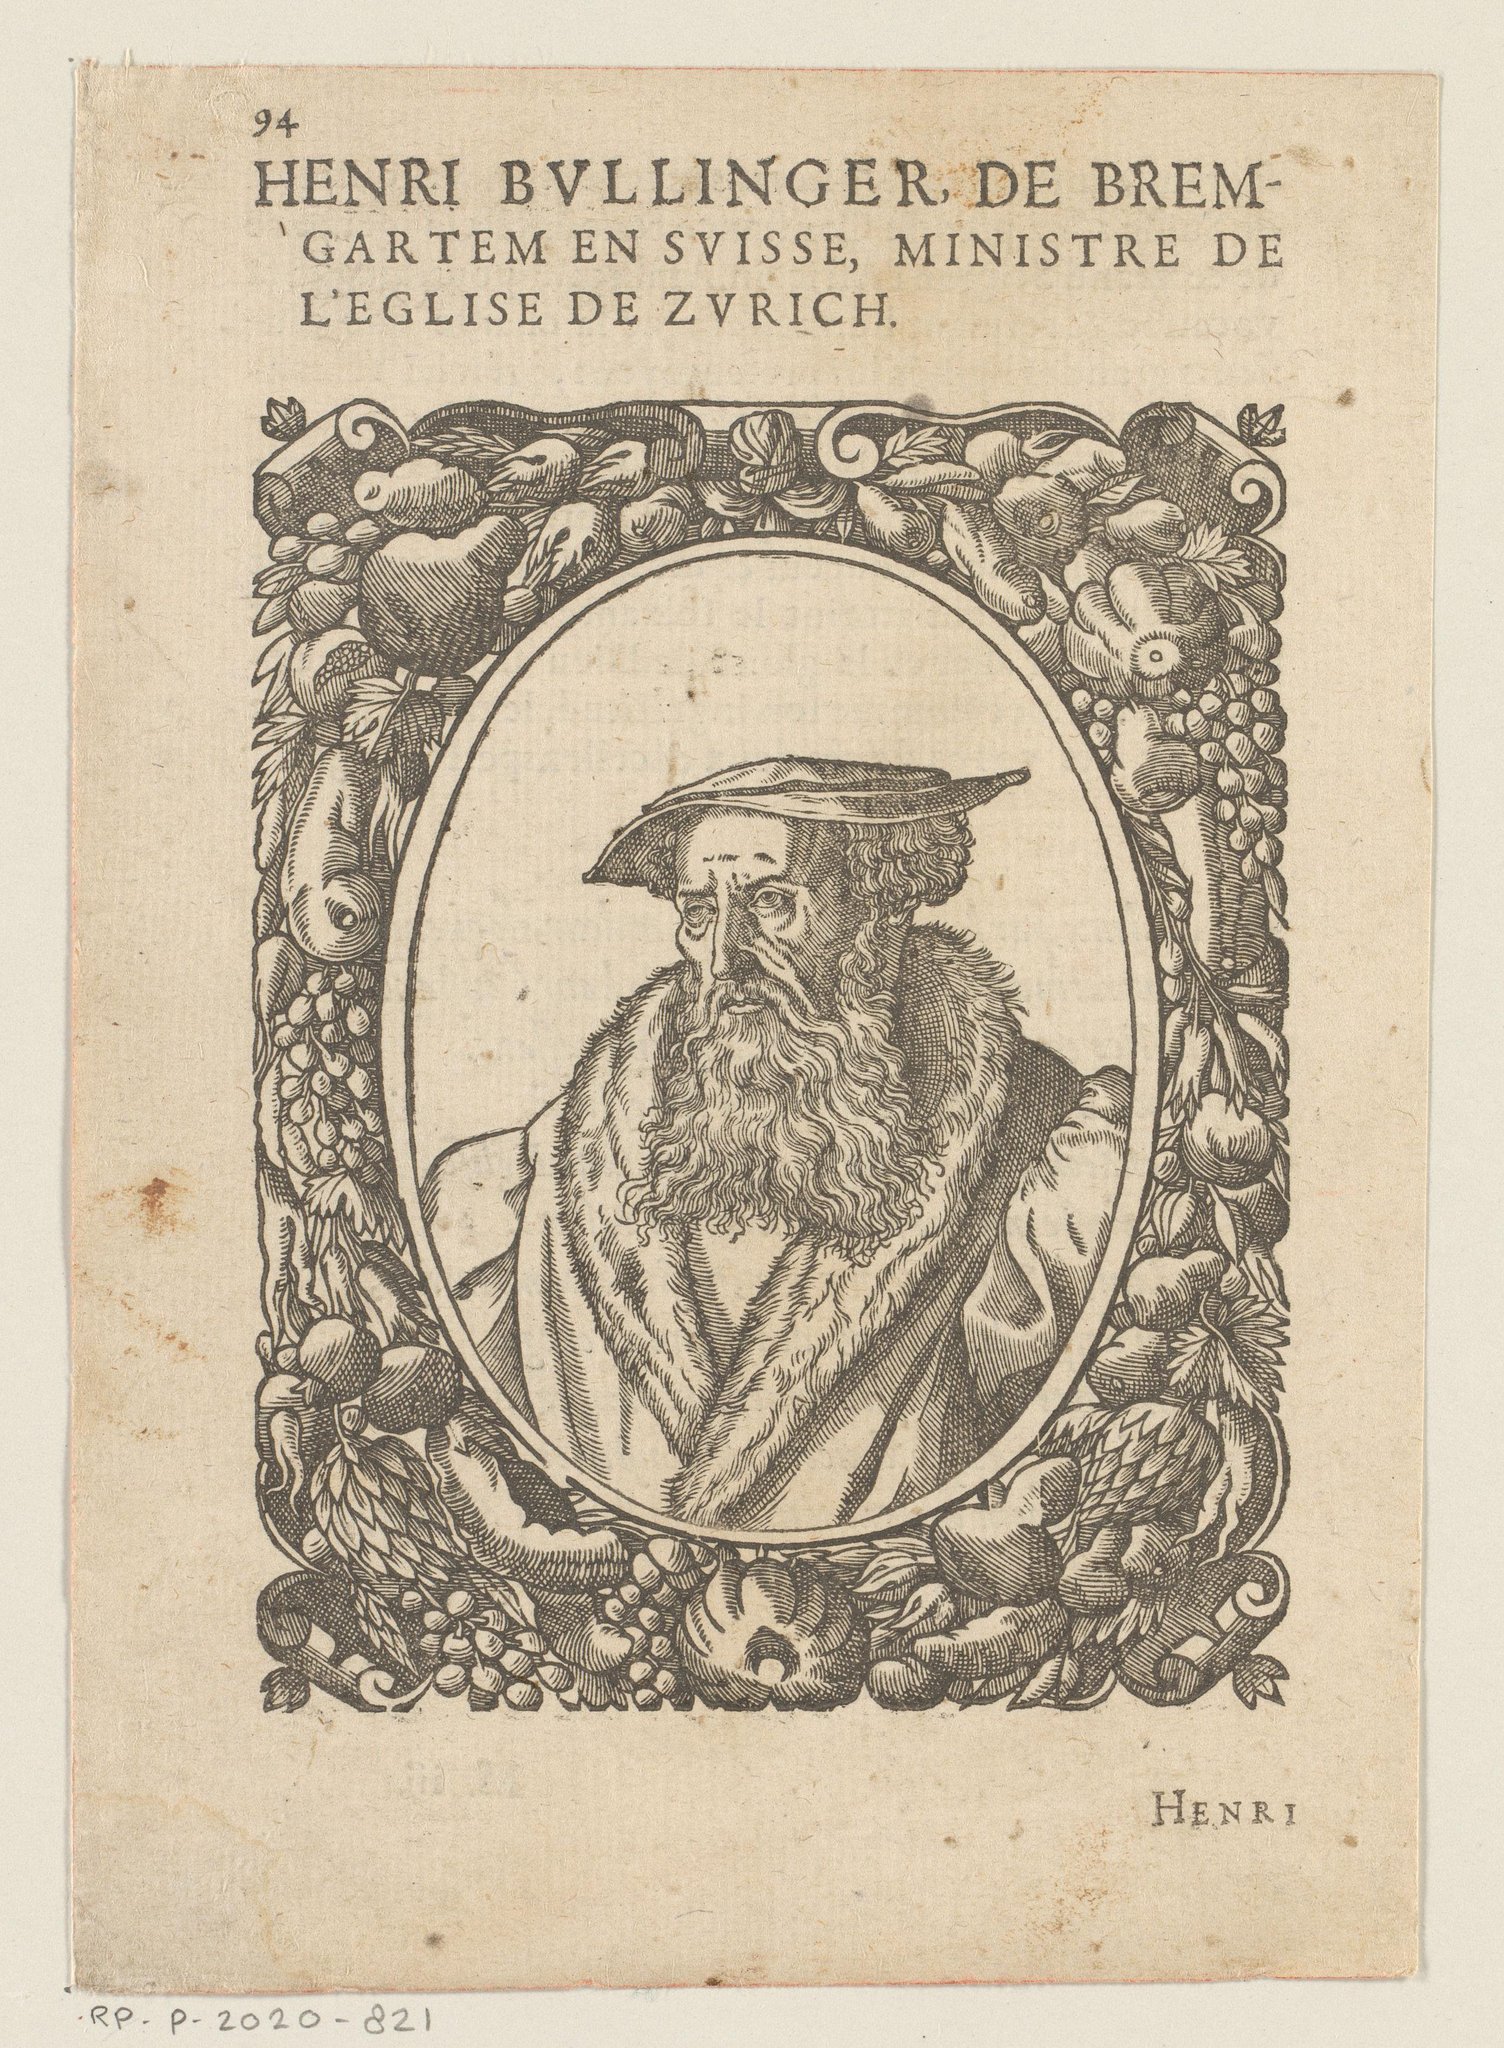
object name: book illustration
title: Portret van Heinrich Bullinger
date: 1581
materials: paper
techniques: letterpress printing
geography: geneva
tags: theologian, historical persons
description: Prent uit: Beze, Theodore de. Les vrais pourtraits des hommes illustres en piete et doctrine (...). Genève: Jean de Laon, 1581, p. 94. Prent eerder gebruikt in: Beze, Theodore de. Icones id est verae imagines virorum doctrina simul et pietate illustrium (...). Genève: Jean de Laon, 1580. Mogelijk ook gebruikt in andere publicaties.